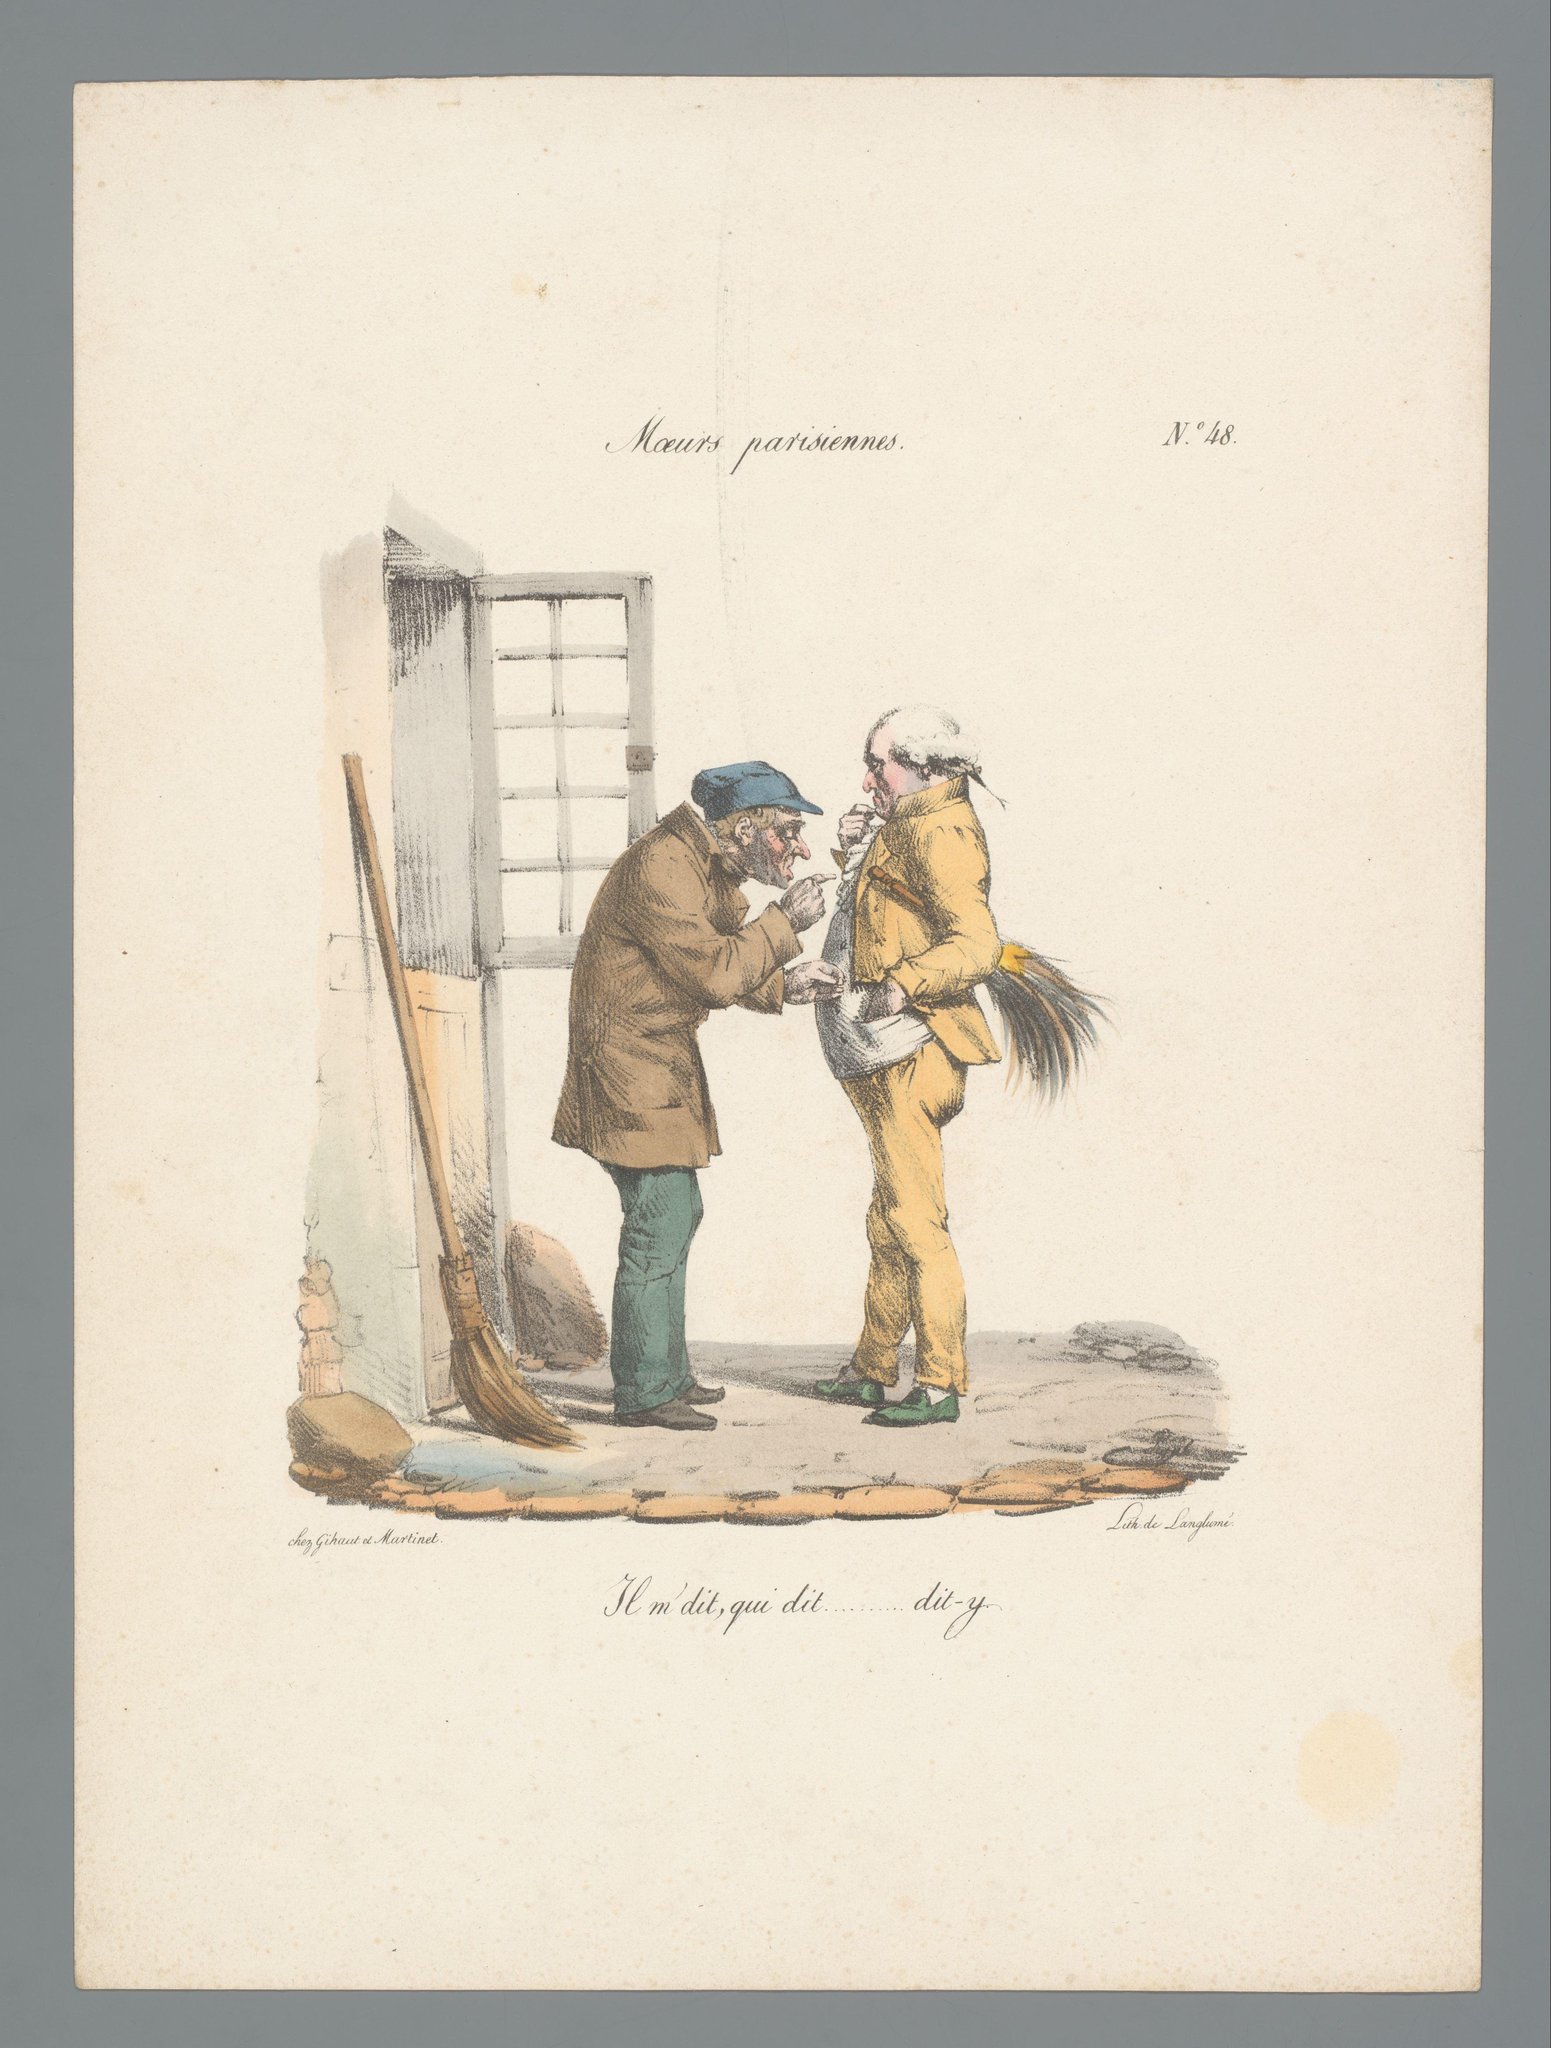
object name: print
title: Zeden en gewoonten van Parijs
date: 1825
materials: paper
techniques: hand coloring, lithograph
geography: paris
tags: adult man, street sweeping, street sweeper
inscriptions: collector's mark: Lugt 2228